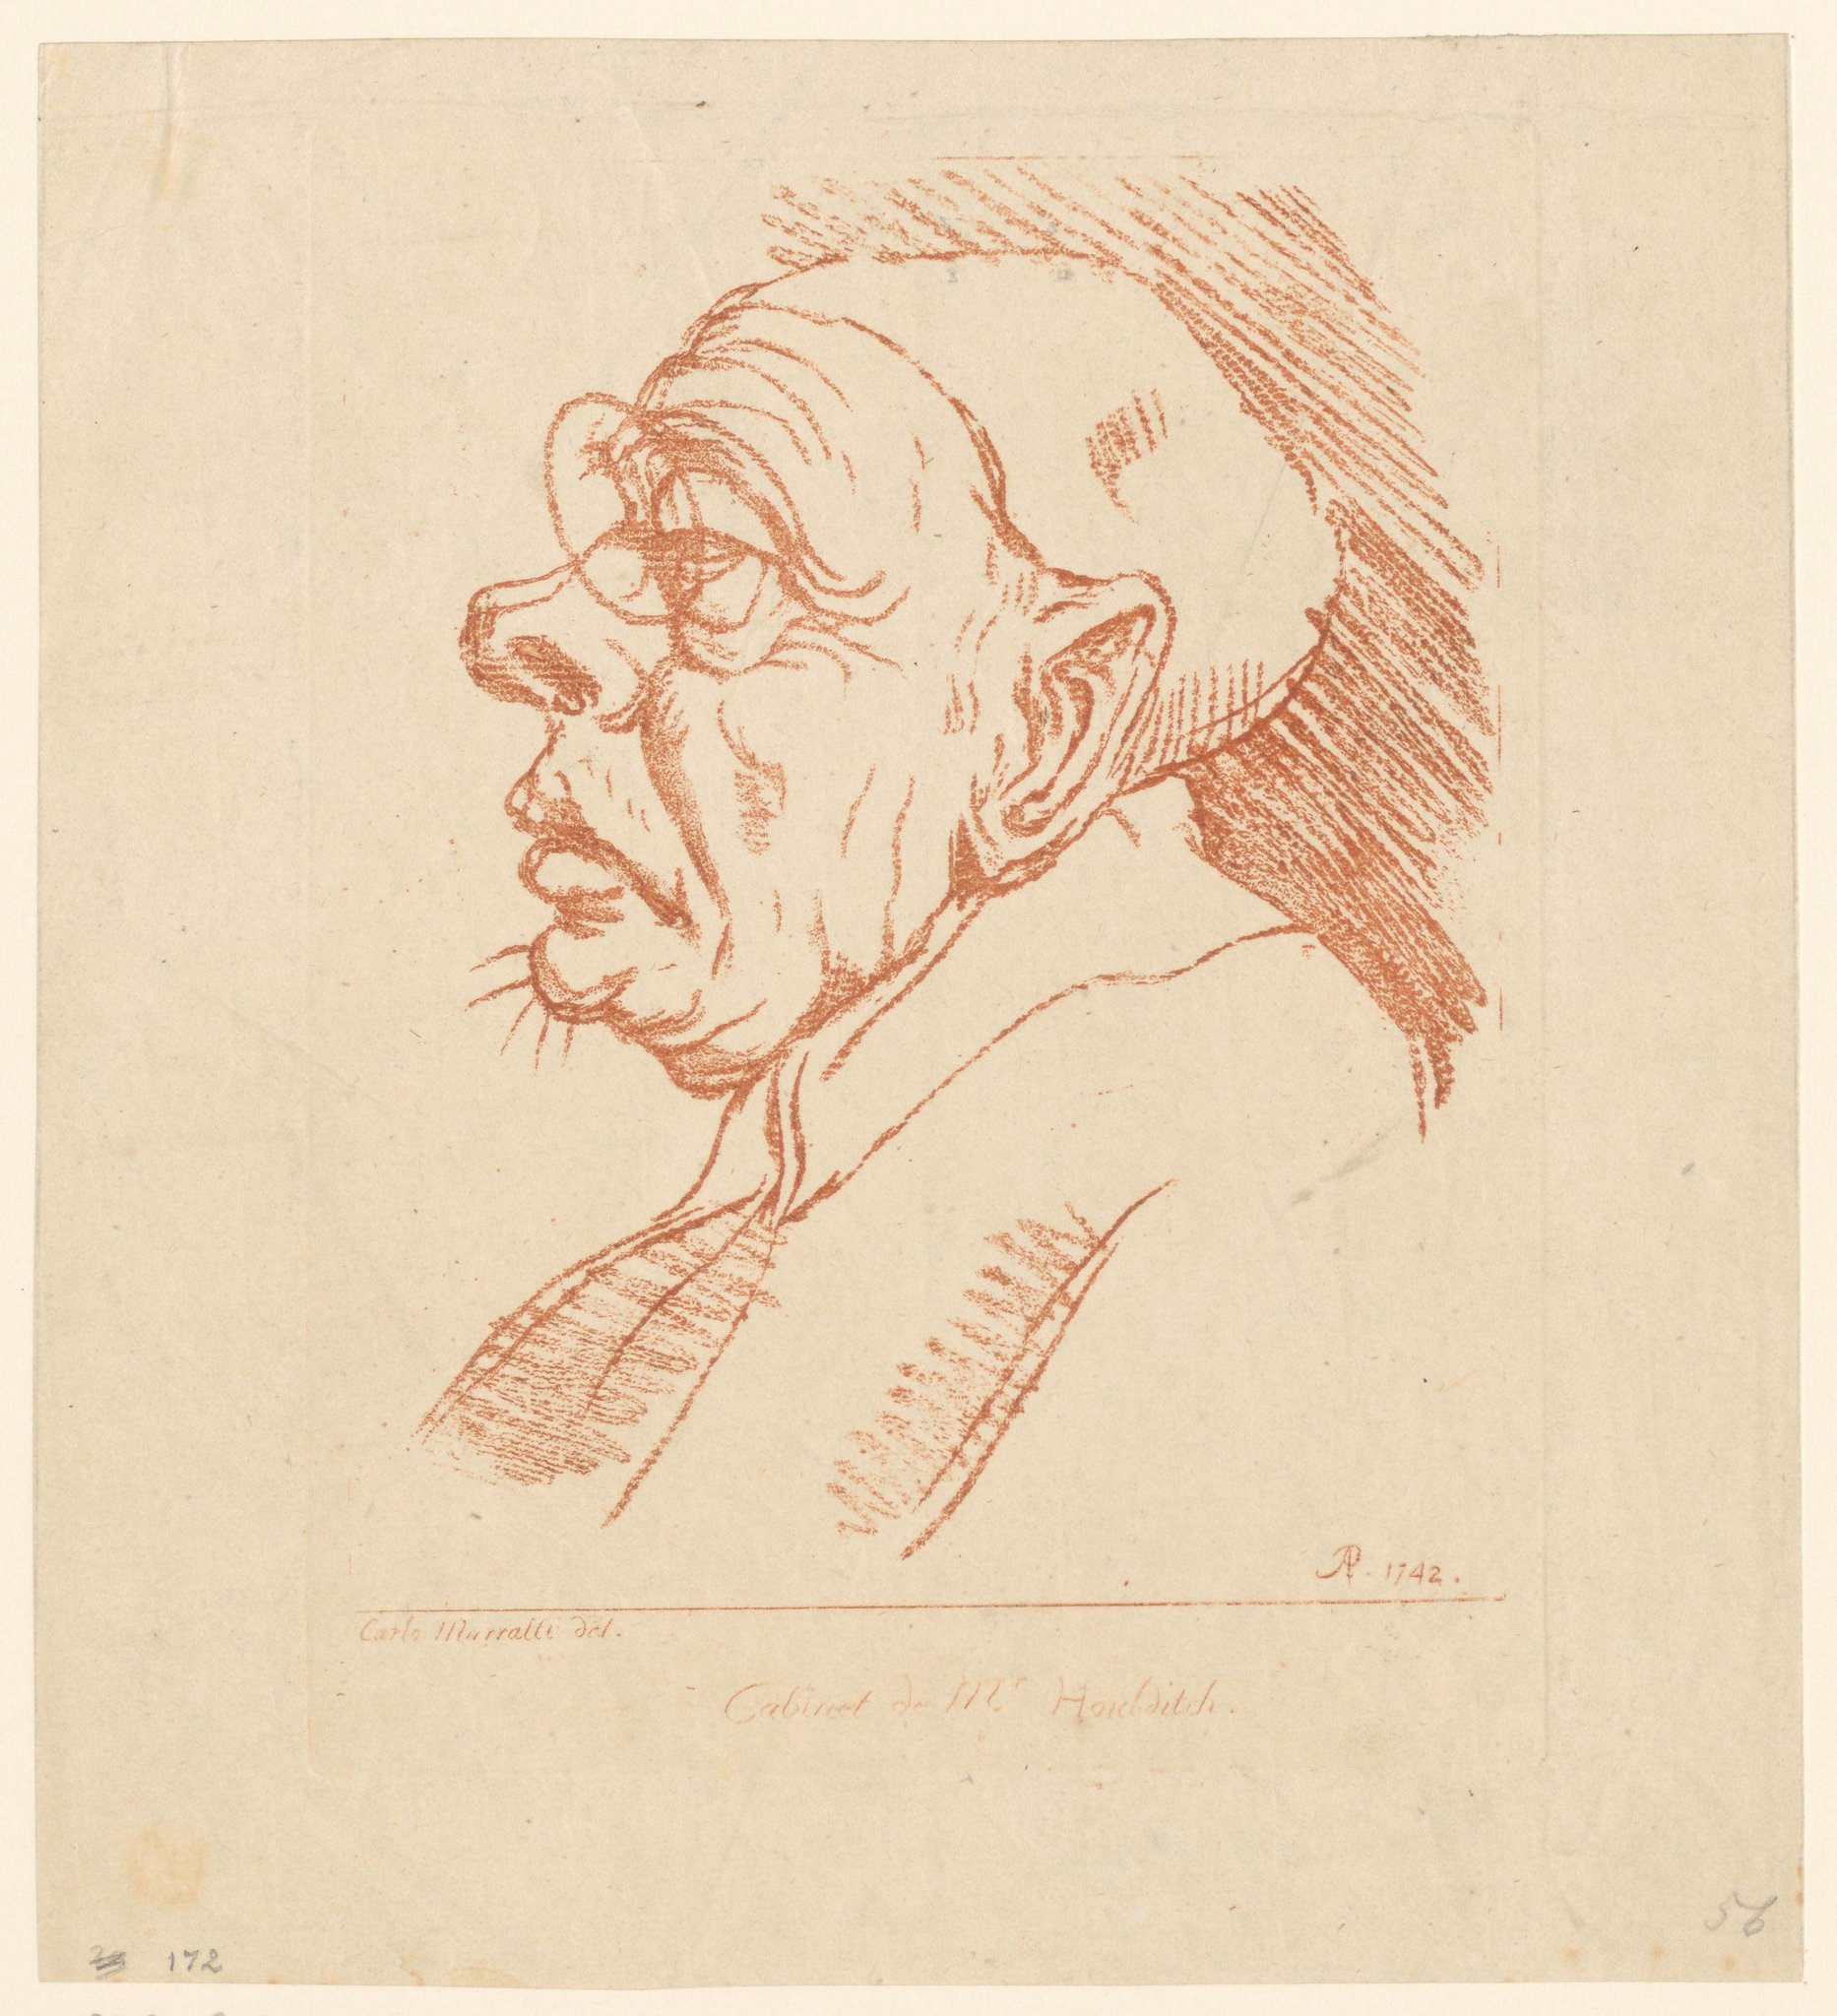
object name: print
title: Karikaturen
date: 1742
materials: paper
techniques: printmaking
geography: great britain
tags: monocle, single lorgnette, caricatures (human types)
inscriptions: collector's mark: Lugt 240